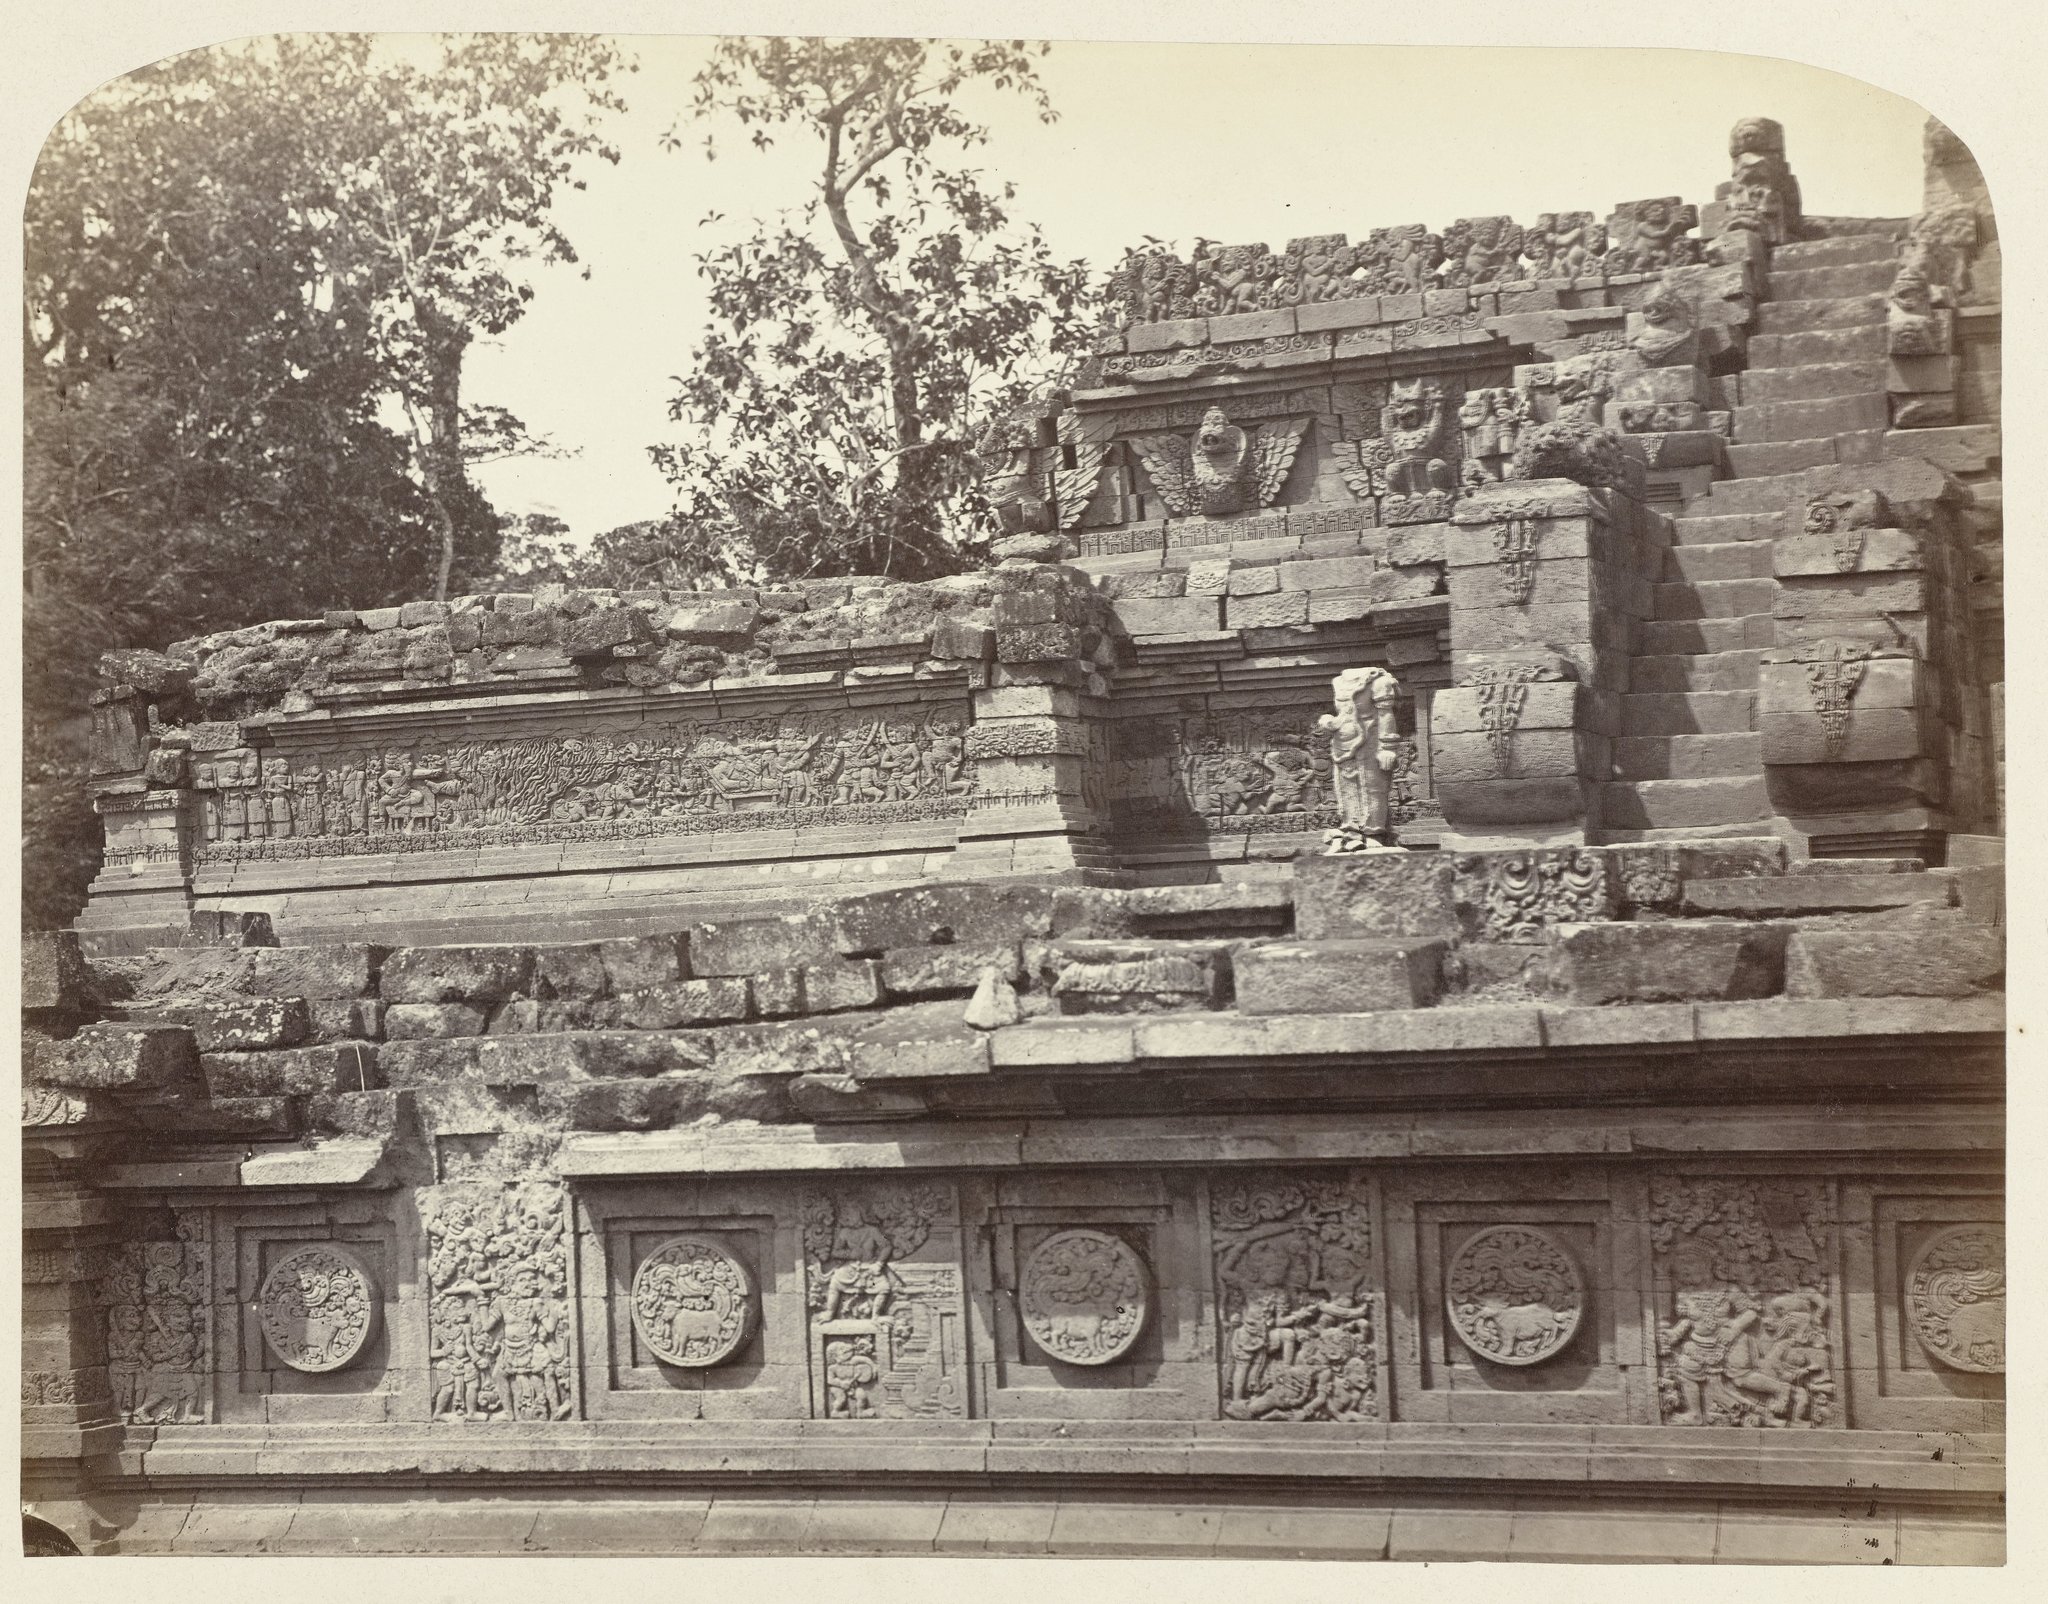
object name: photograph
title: Het bovenste gedeelte van Candi Panataran en de trap gezien vanaf de westzijde.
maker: isidore kinsbergen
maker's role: fotograaf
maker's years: 1821-1905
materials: cardboard, paper, photographic support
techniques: albumen print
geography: java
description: Candi Panataran (Temple Complex), main Temple; Partial view of the facade, west side. Panataran, Blitar district, East Java province 1323-1347 AD.